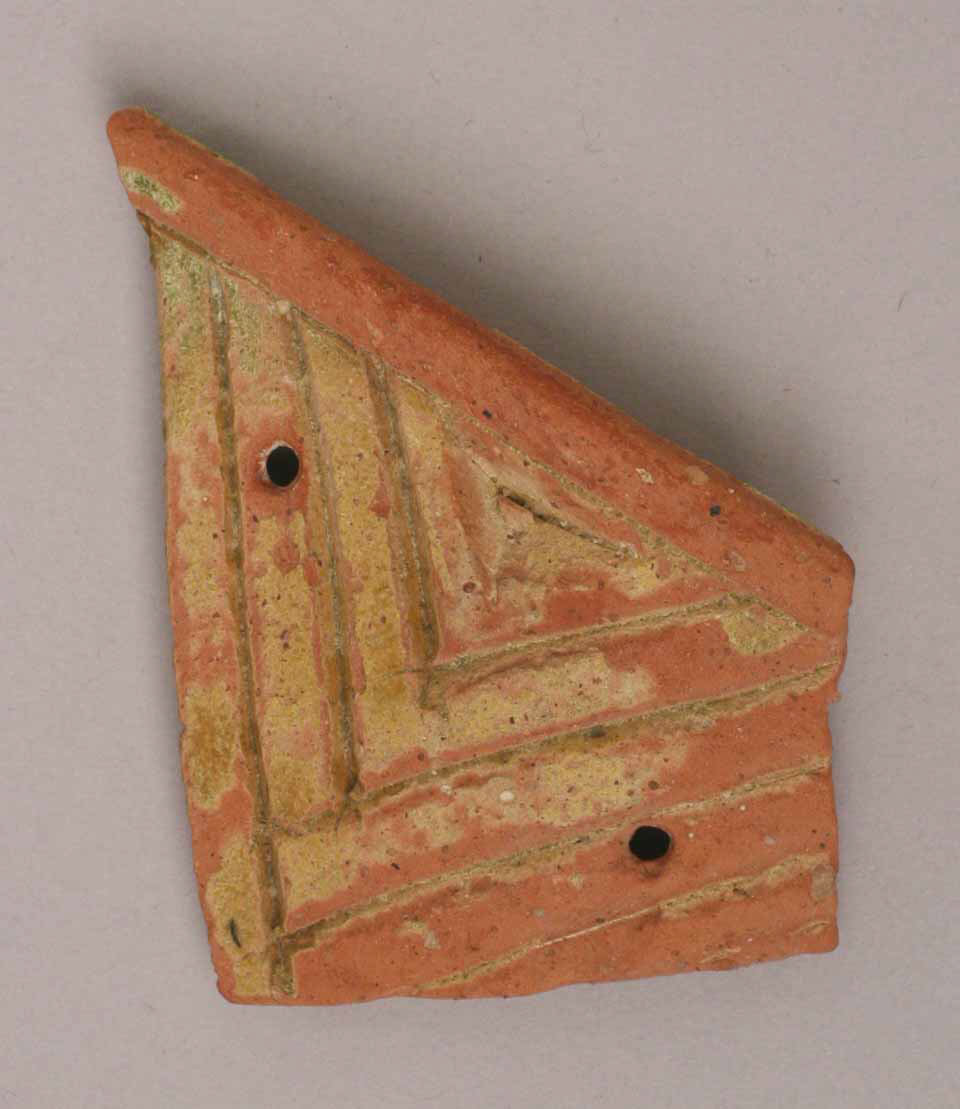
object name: fragment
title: Ceramic Fragment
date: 1001-1100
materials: earthenware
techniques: glazing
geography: saudi arabia